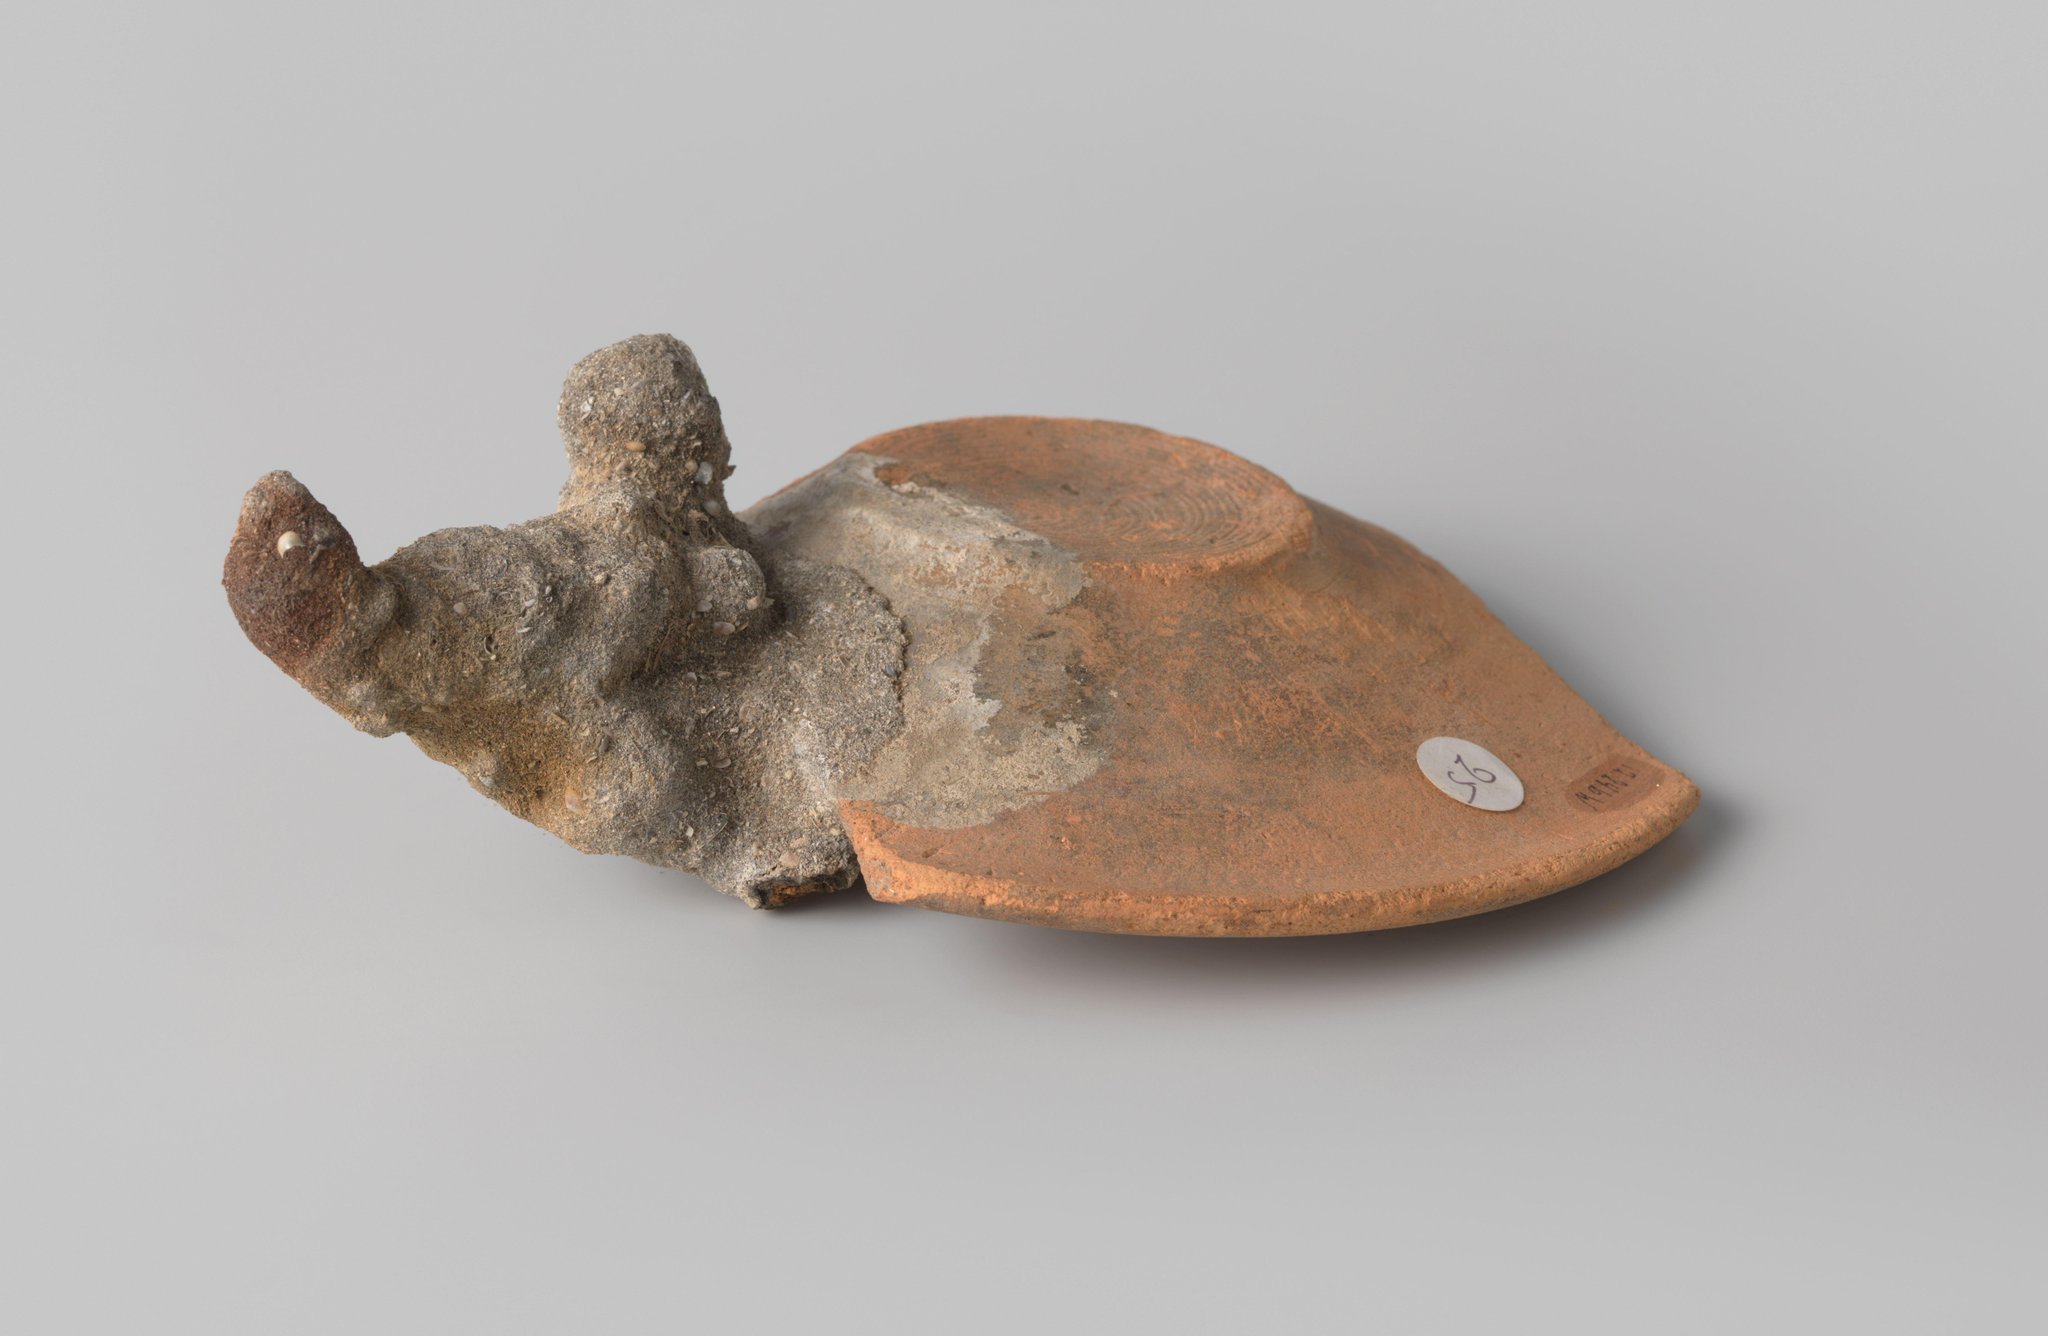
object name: martavaan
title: Deksel met concretie van martavaan uit V.O.C.-schip de 'Witte Leeuw'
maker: Anonymous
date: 1613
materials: earthenware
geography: southeast asia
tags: verenigde oostindische compagnie, sint-helena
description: An earthenware cover. The round cover have a concave base and usually a knob on top. The clay is orange red, brown, grey or cream-coloured and contains impurities. The inside of the covers show signs of scratches indicating that a sharp tool has been used to even out the clay. The body is orangr-red with black and white specks. The rim is decorated with an incised line. On the top is a conical shaped knob.